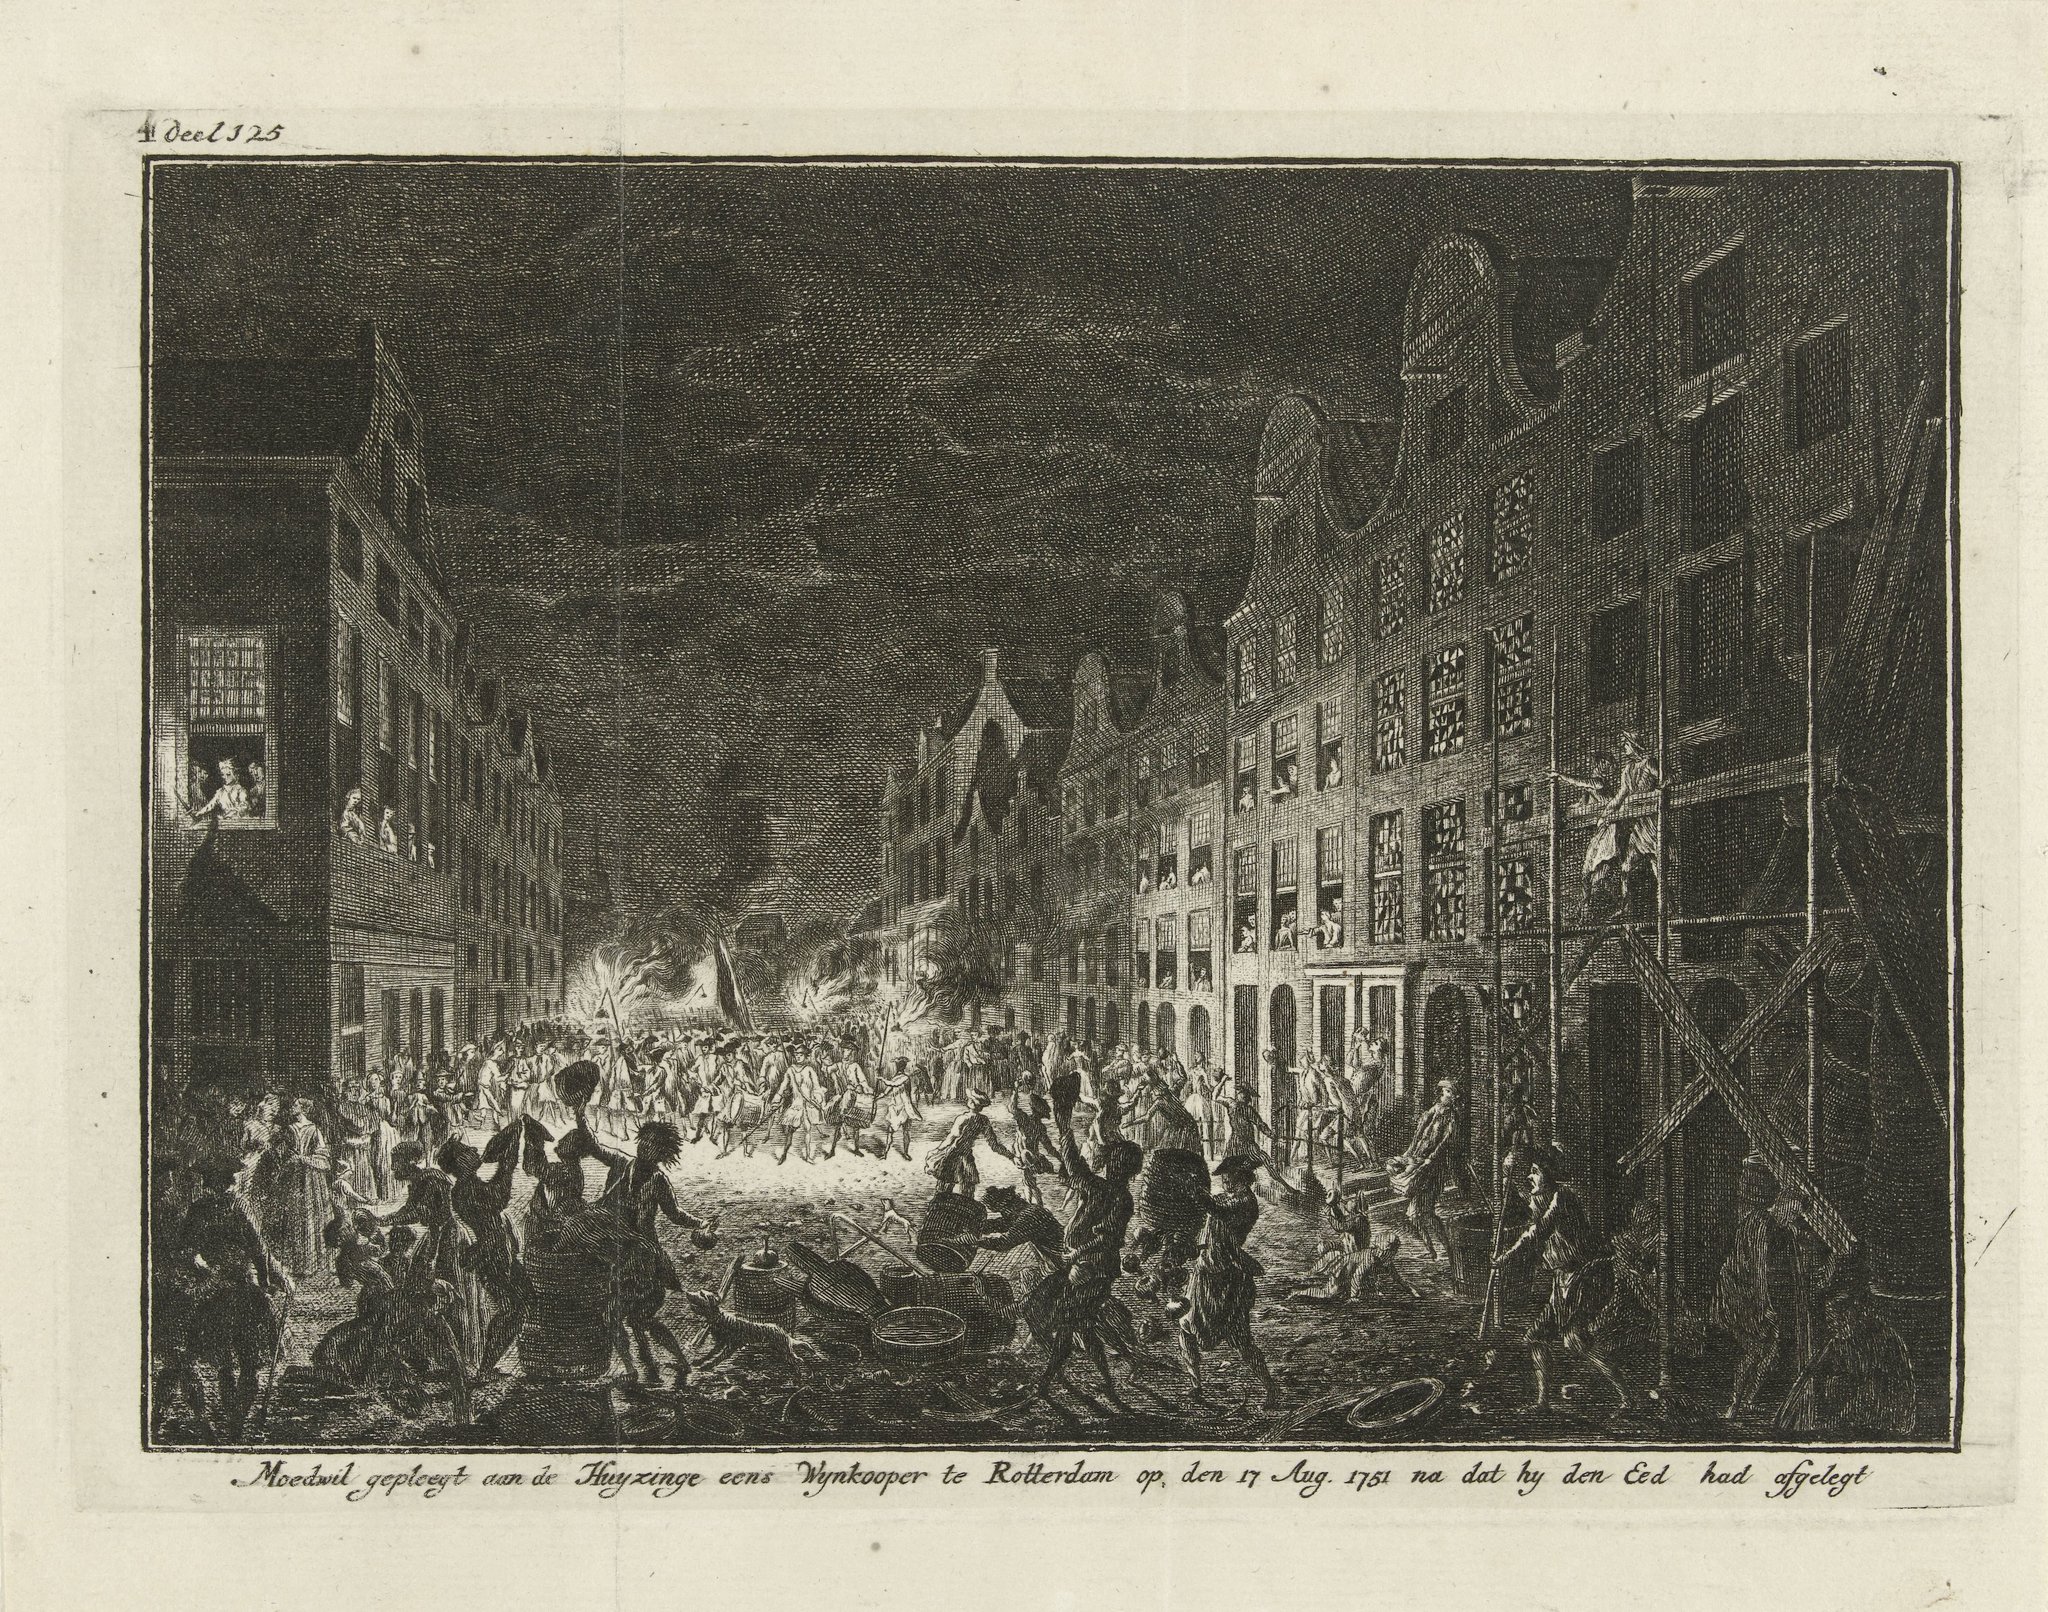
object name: print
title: Moedwil gepleegd aan de Huizinge eens Wynkoopers te Rotterdam op den 17 Aug. 1751, na dat hy den Eed had afgelegt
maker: Anonymous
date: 1751-1753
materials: paper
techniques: engraving, etching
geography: northern netherlands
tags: plundering ~ riot, rotterdam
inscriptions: collector's mark: Lugt 2228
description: Plundering van het huis van de wijnkoper Gerrit Hagedooren (Hagedoorn) in de Bierstraat te Rotterdam in de avond van 17 augustus 1751 nadat hij de eed had afgelegd. Rellen in een straat met rechts het huis van de wijnkoper met ingegooide ramenen en met plunderaars die zich te goed doen aan opengebroken wijnvaten. Verderop in de straat de aankomst van een detachement schutters. Gemerkt linksboven: 4 deel 125.